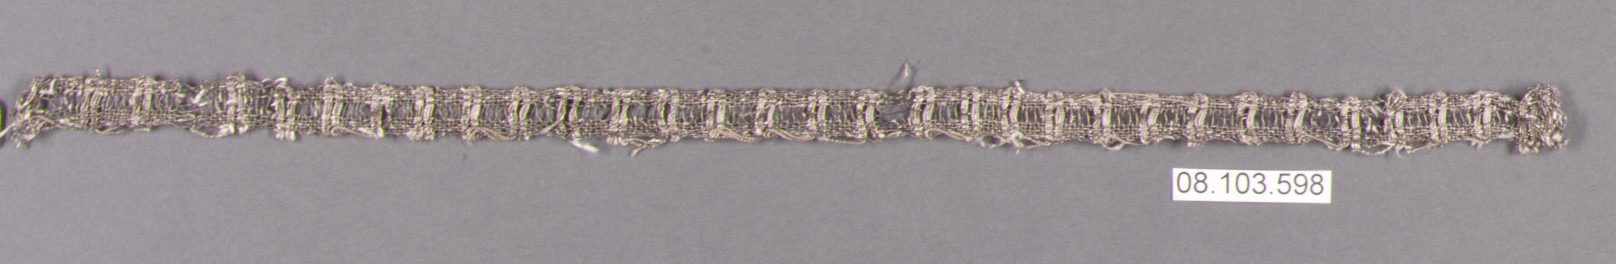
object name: galloon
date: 1701-1800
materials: metal thread